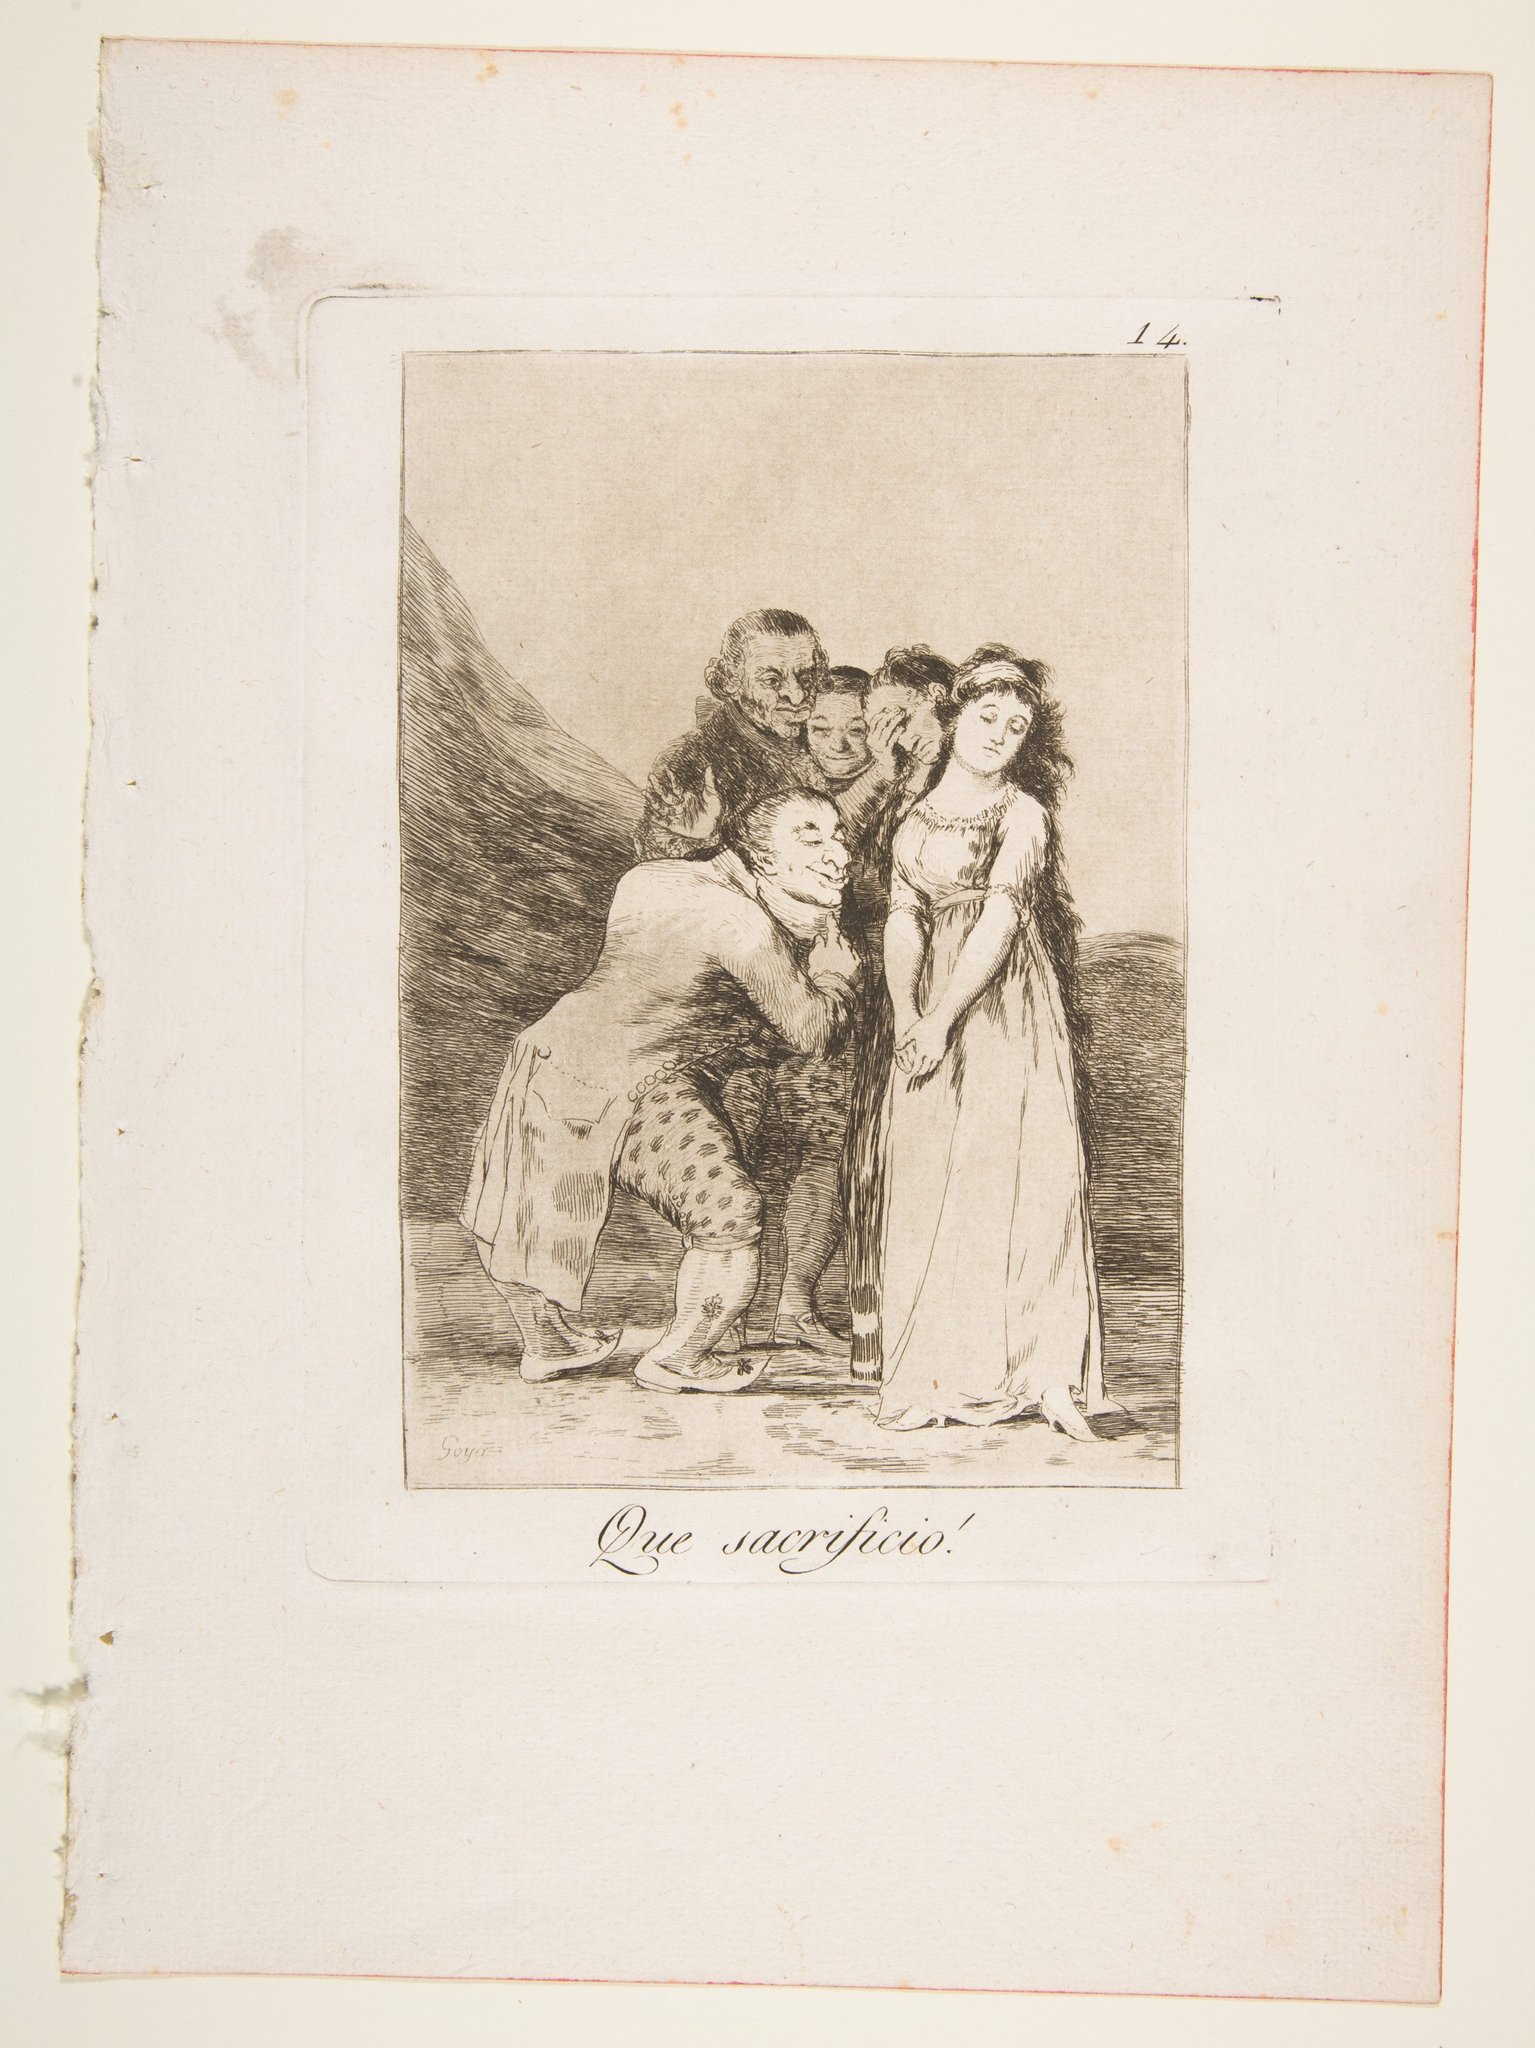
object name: print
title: Plate 14 from "Los Caprichos": What a sacrifice! (Que sacrificio!)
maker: goya (francisco de goya y lucientes)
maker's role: artist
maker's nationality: spanish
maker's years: 1746-1828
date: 1799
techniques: aquatint, burnishing, drypoint, etching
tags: men,women